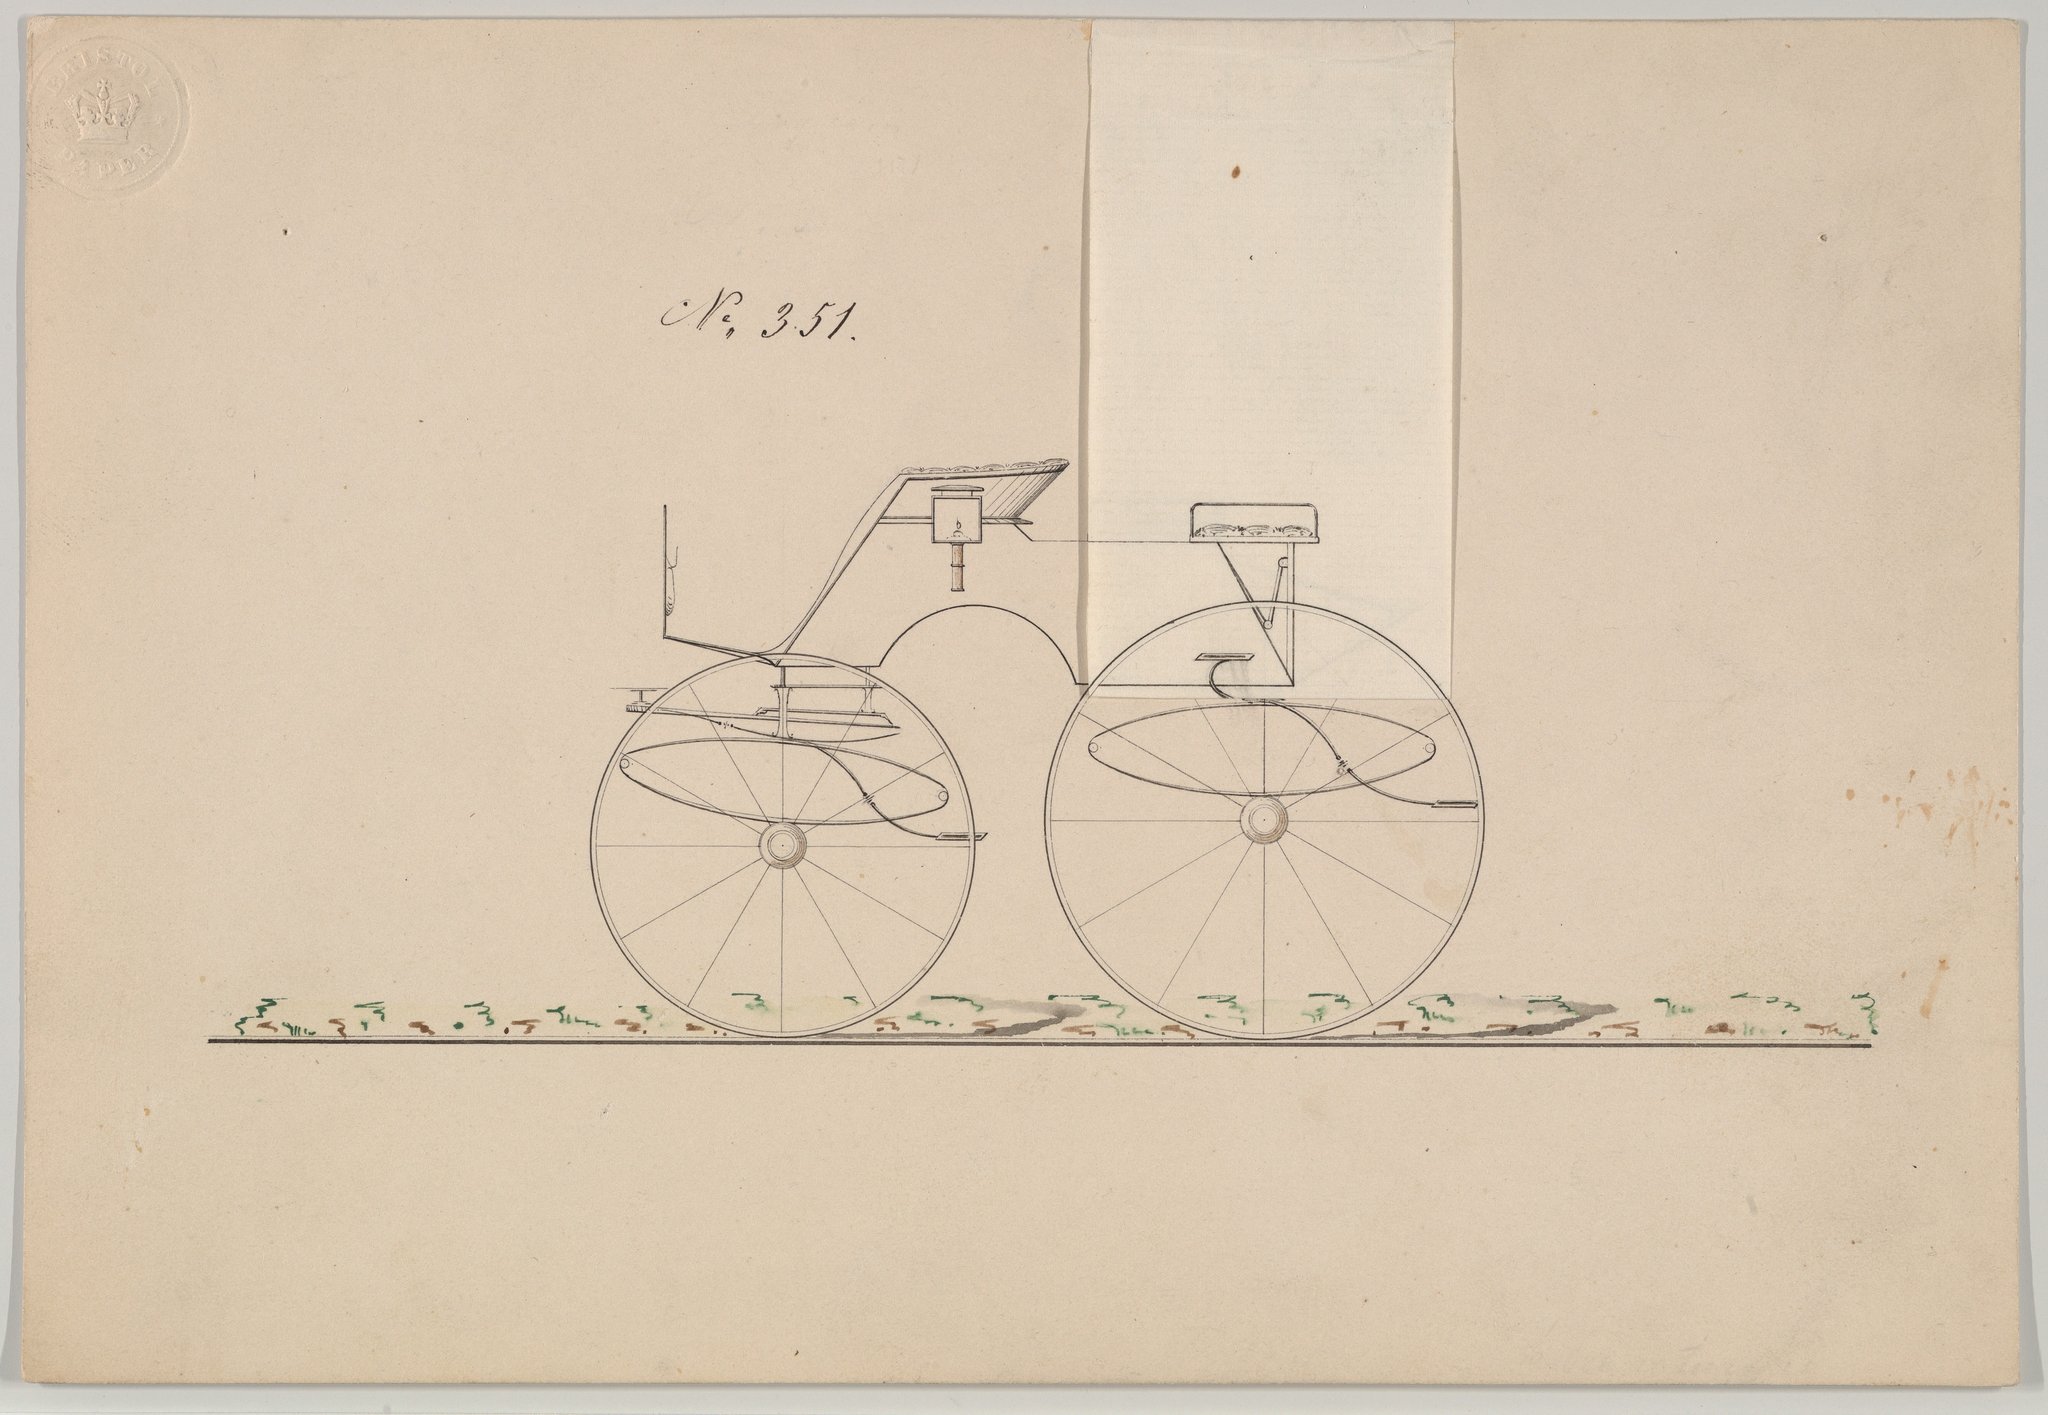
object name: drawing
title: Dog Cart Phaeton #351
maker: brewster & co.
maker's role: manufacturer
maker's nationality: american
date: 1850-1870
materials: gouache, ink, watercolor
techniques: pen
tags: carriages